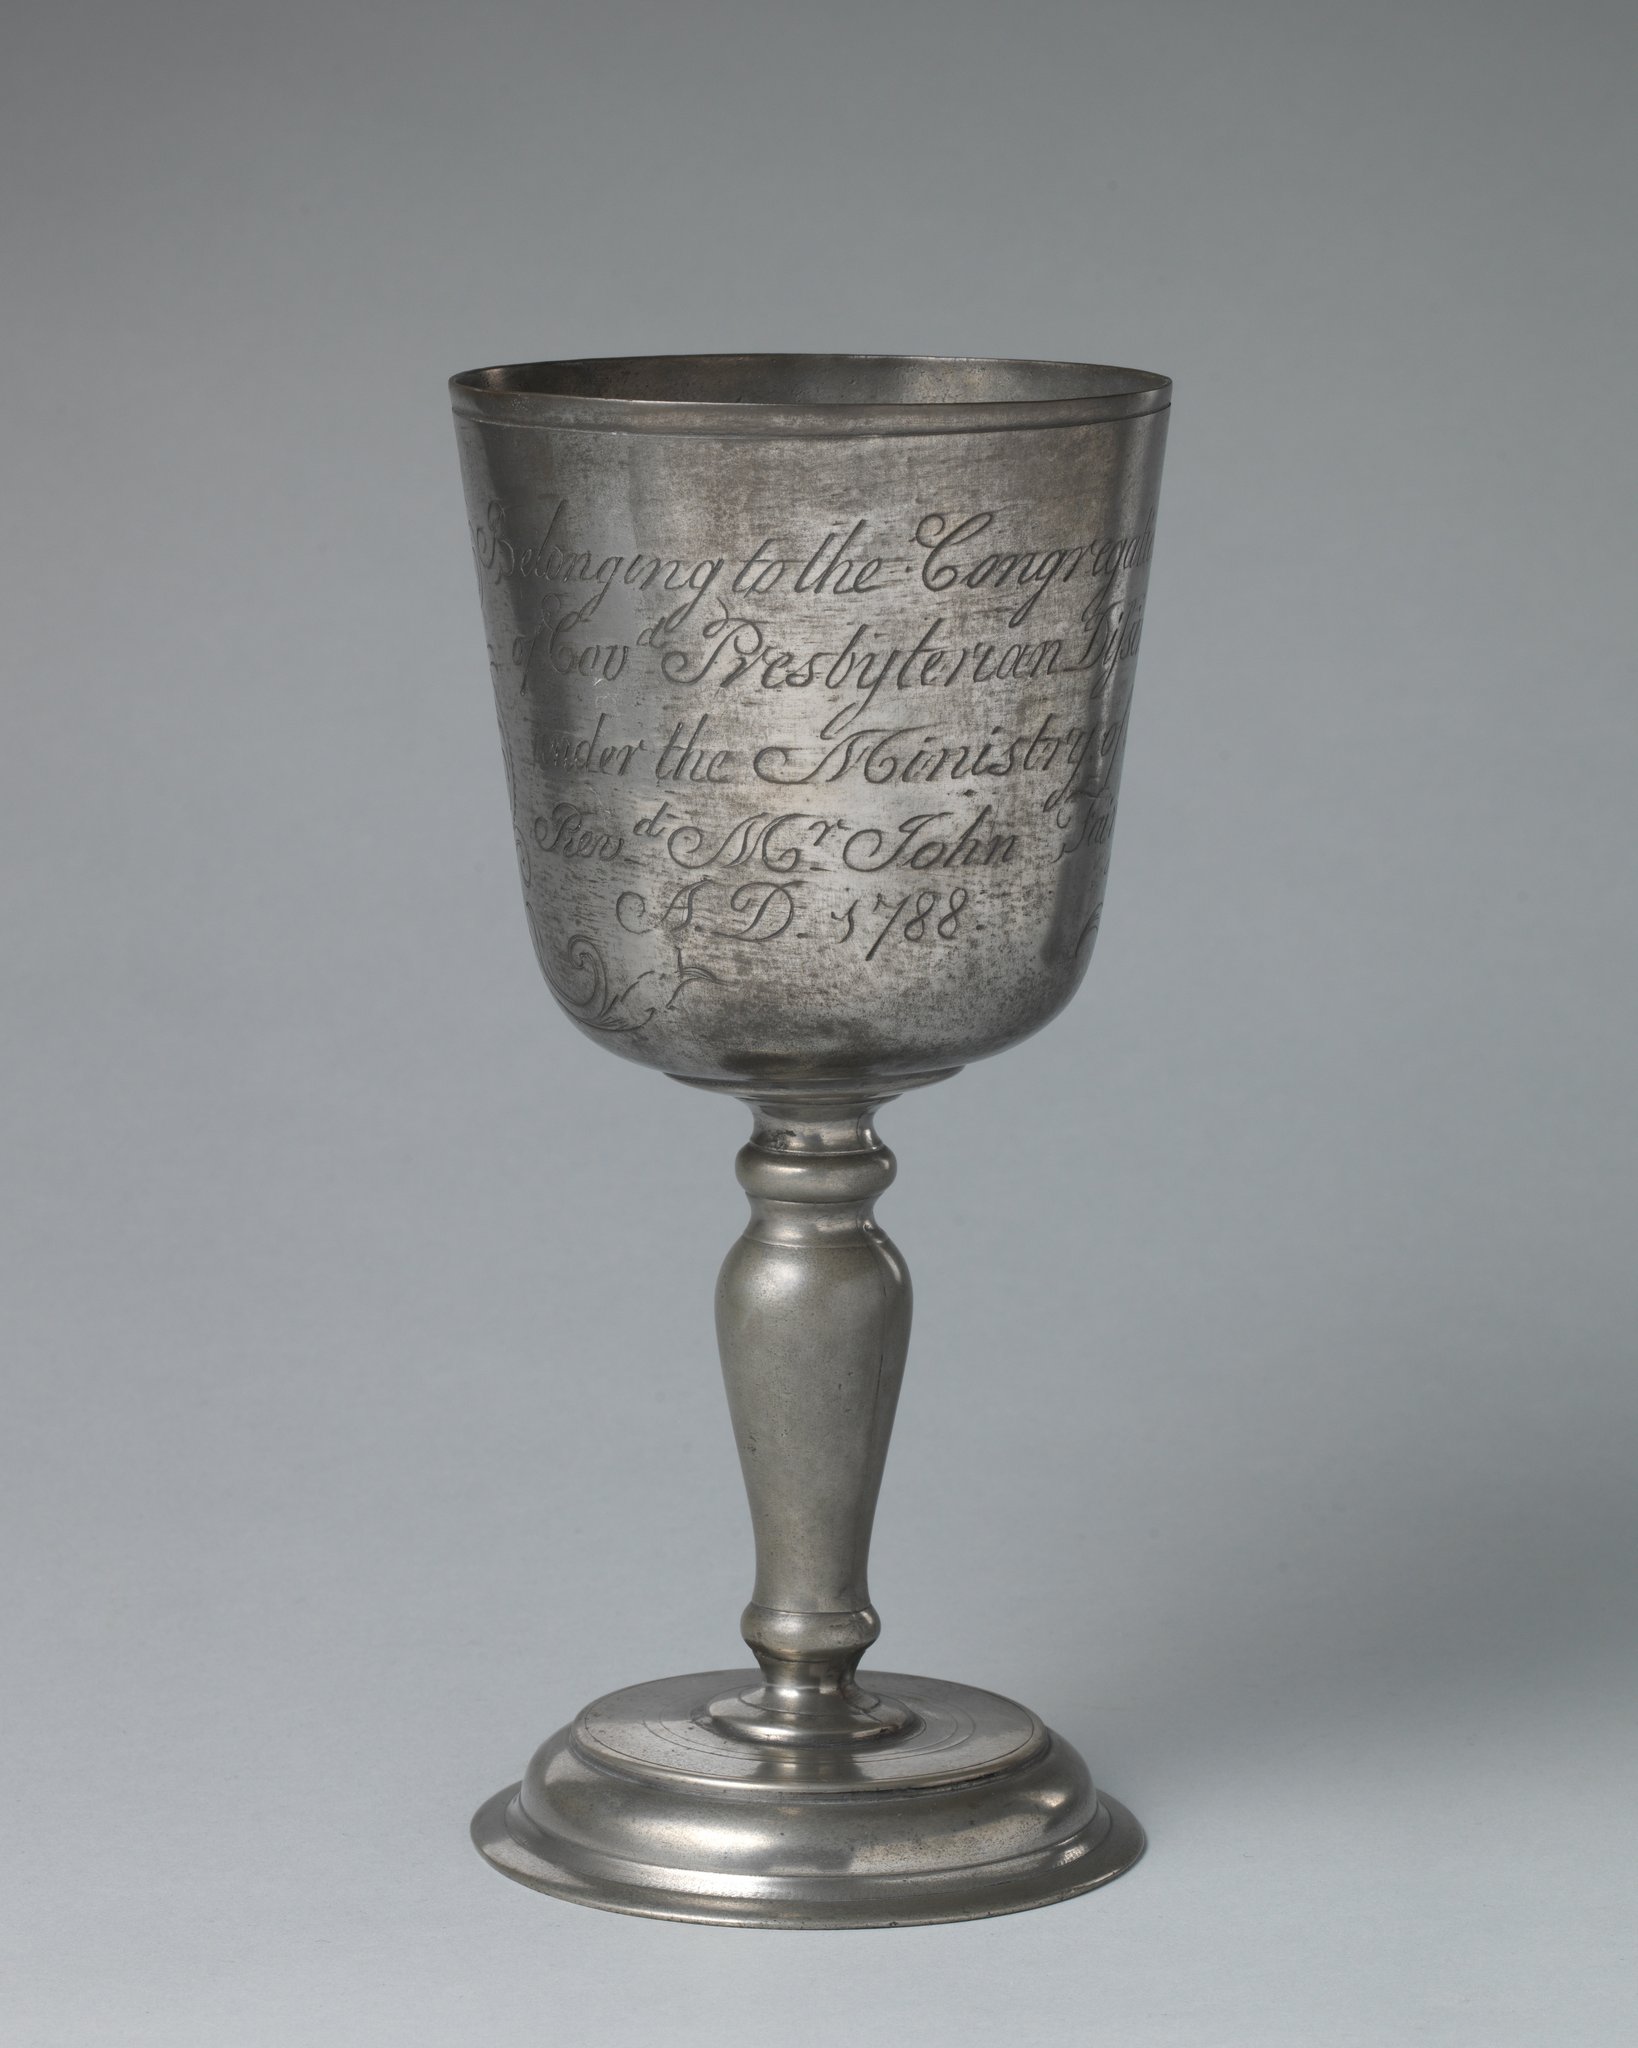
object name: chalice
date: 1788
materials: pewter